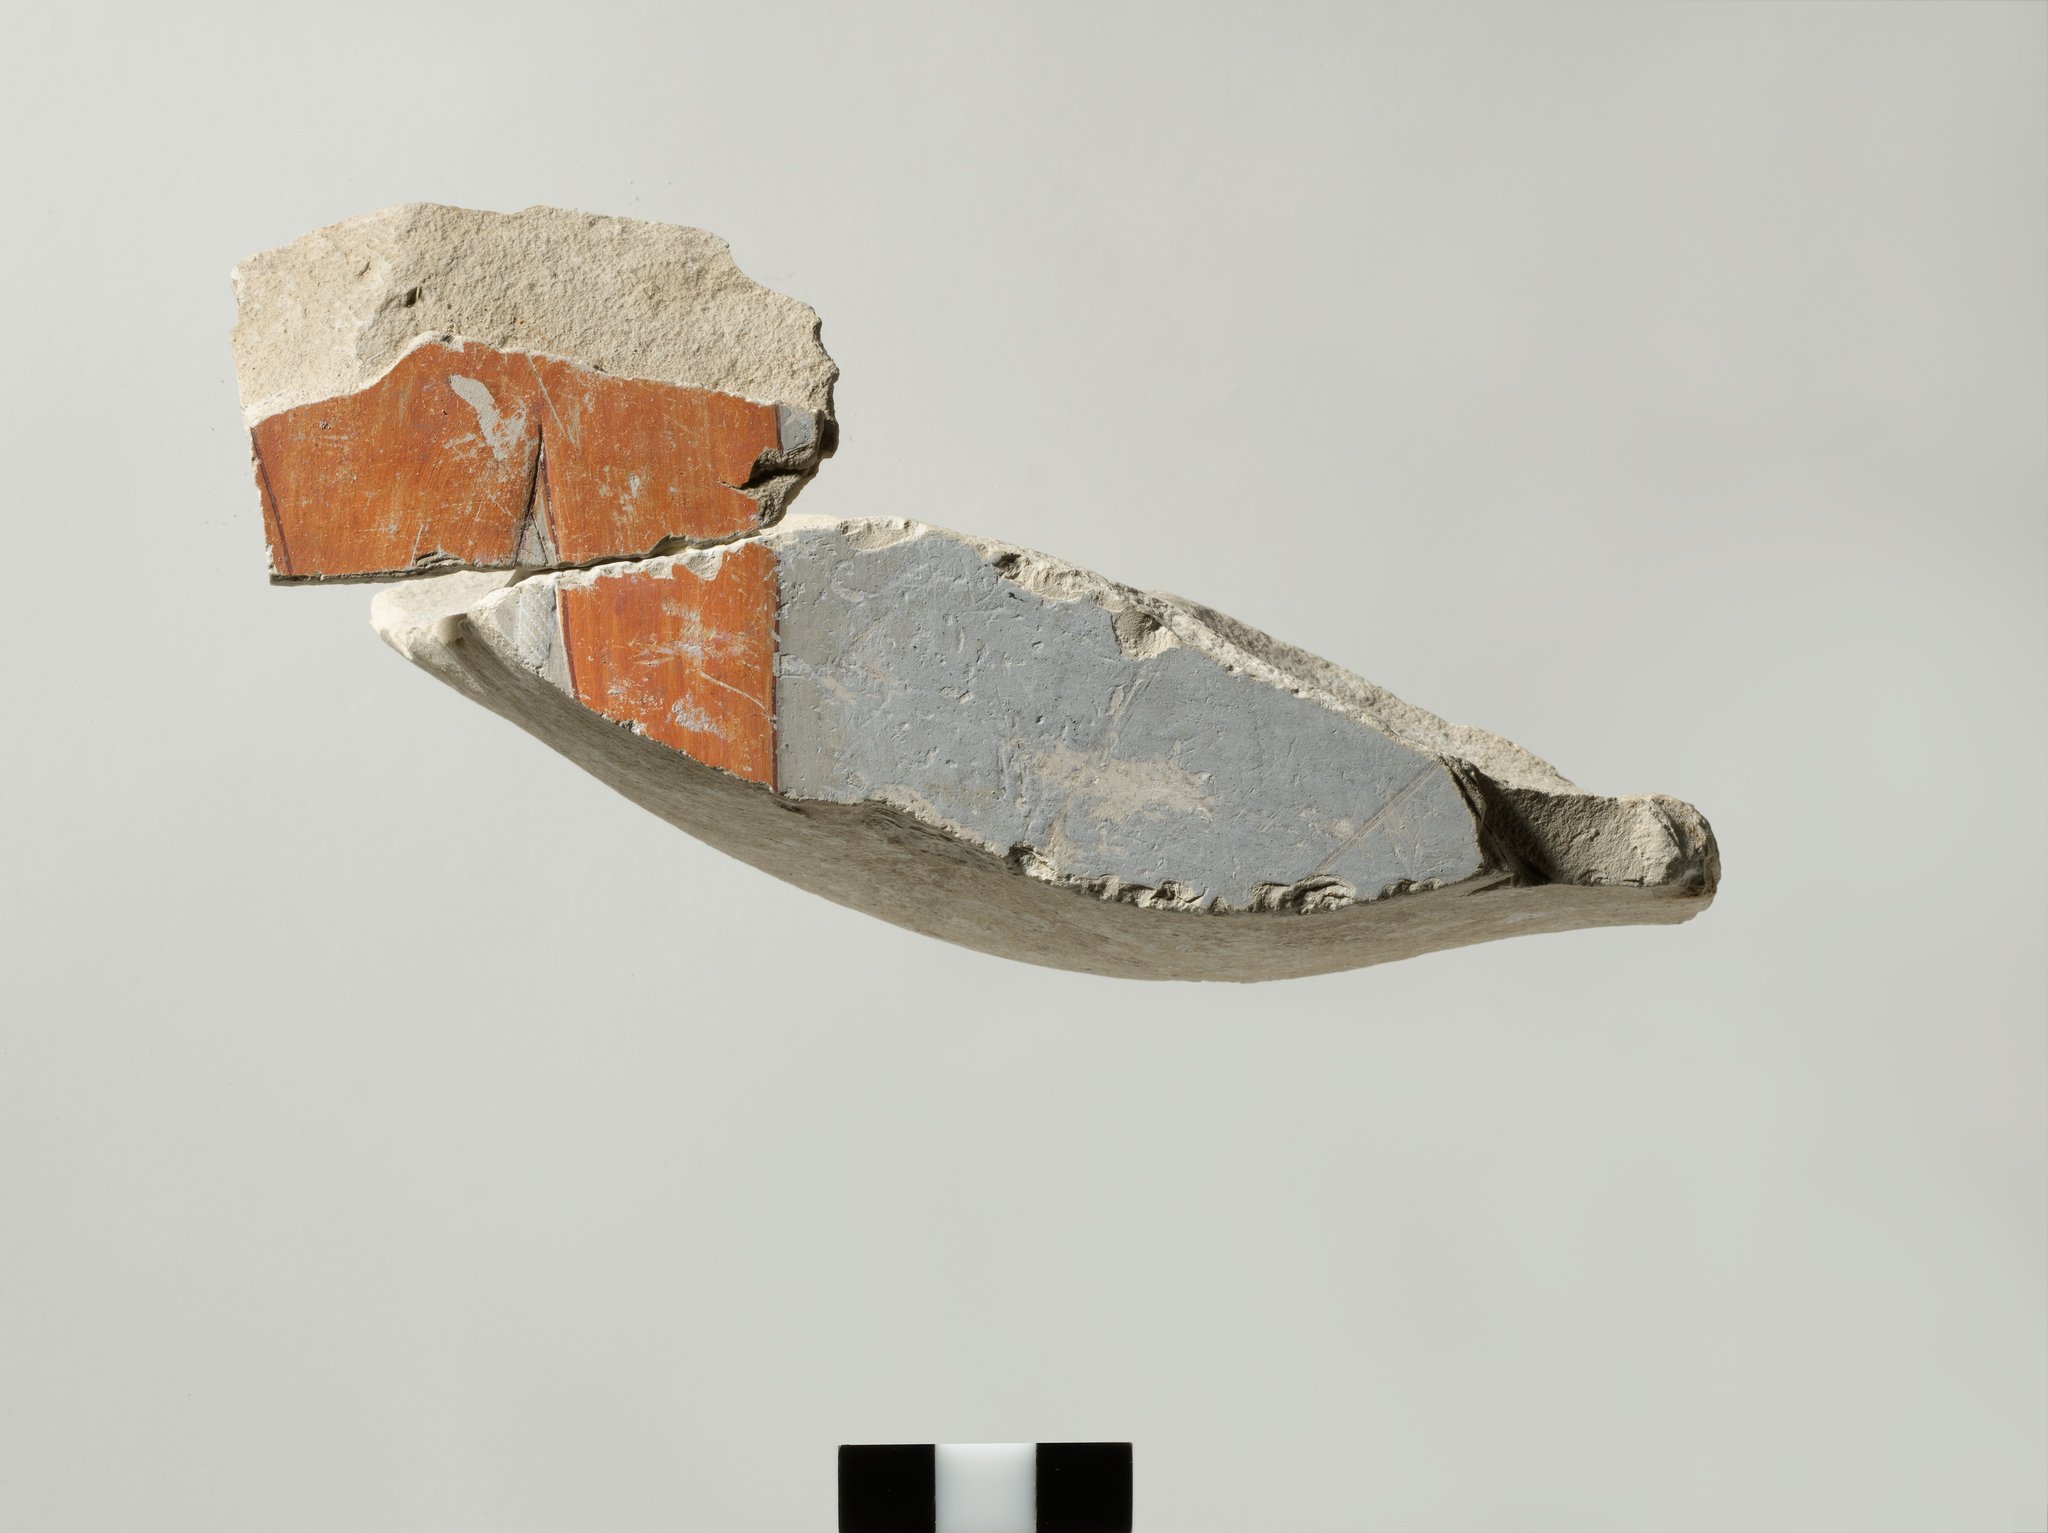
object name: relief fragment, tomb of meketre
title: Relief fragments from the tomb of Meketre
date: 1981-1975 BCE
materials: limestone, paint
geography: egypt